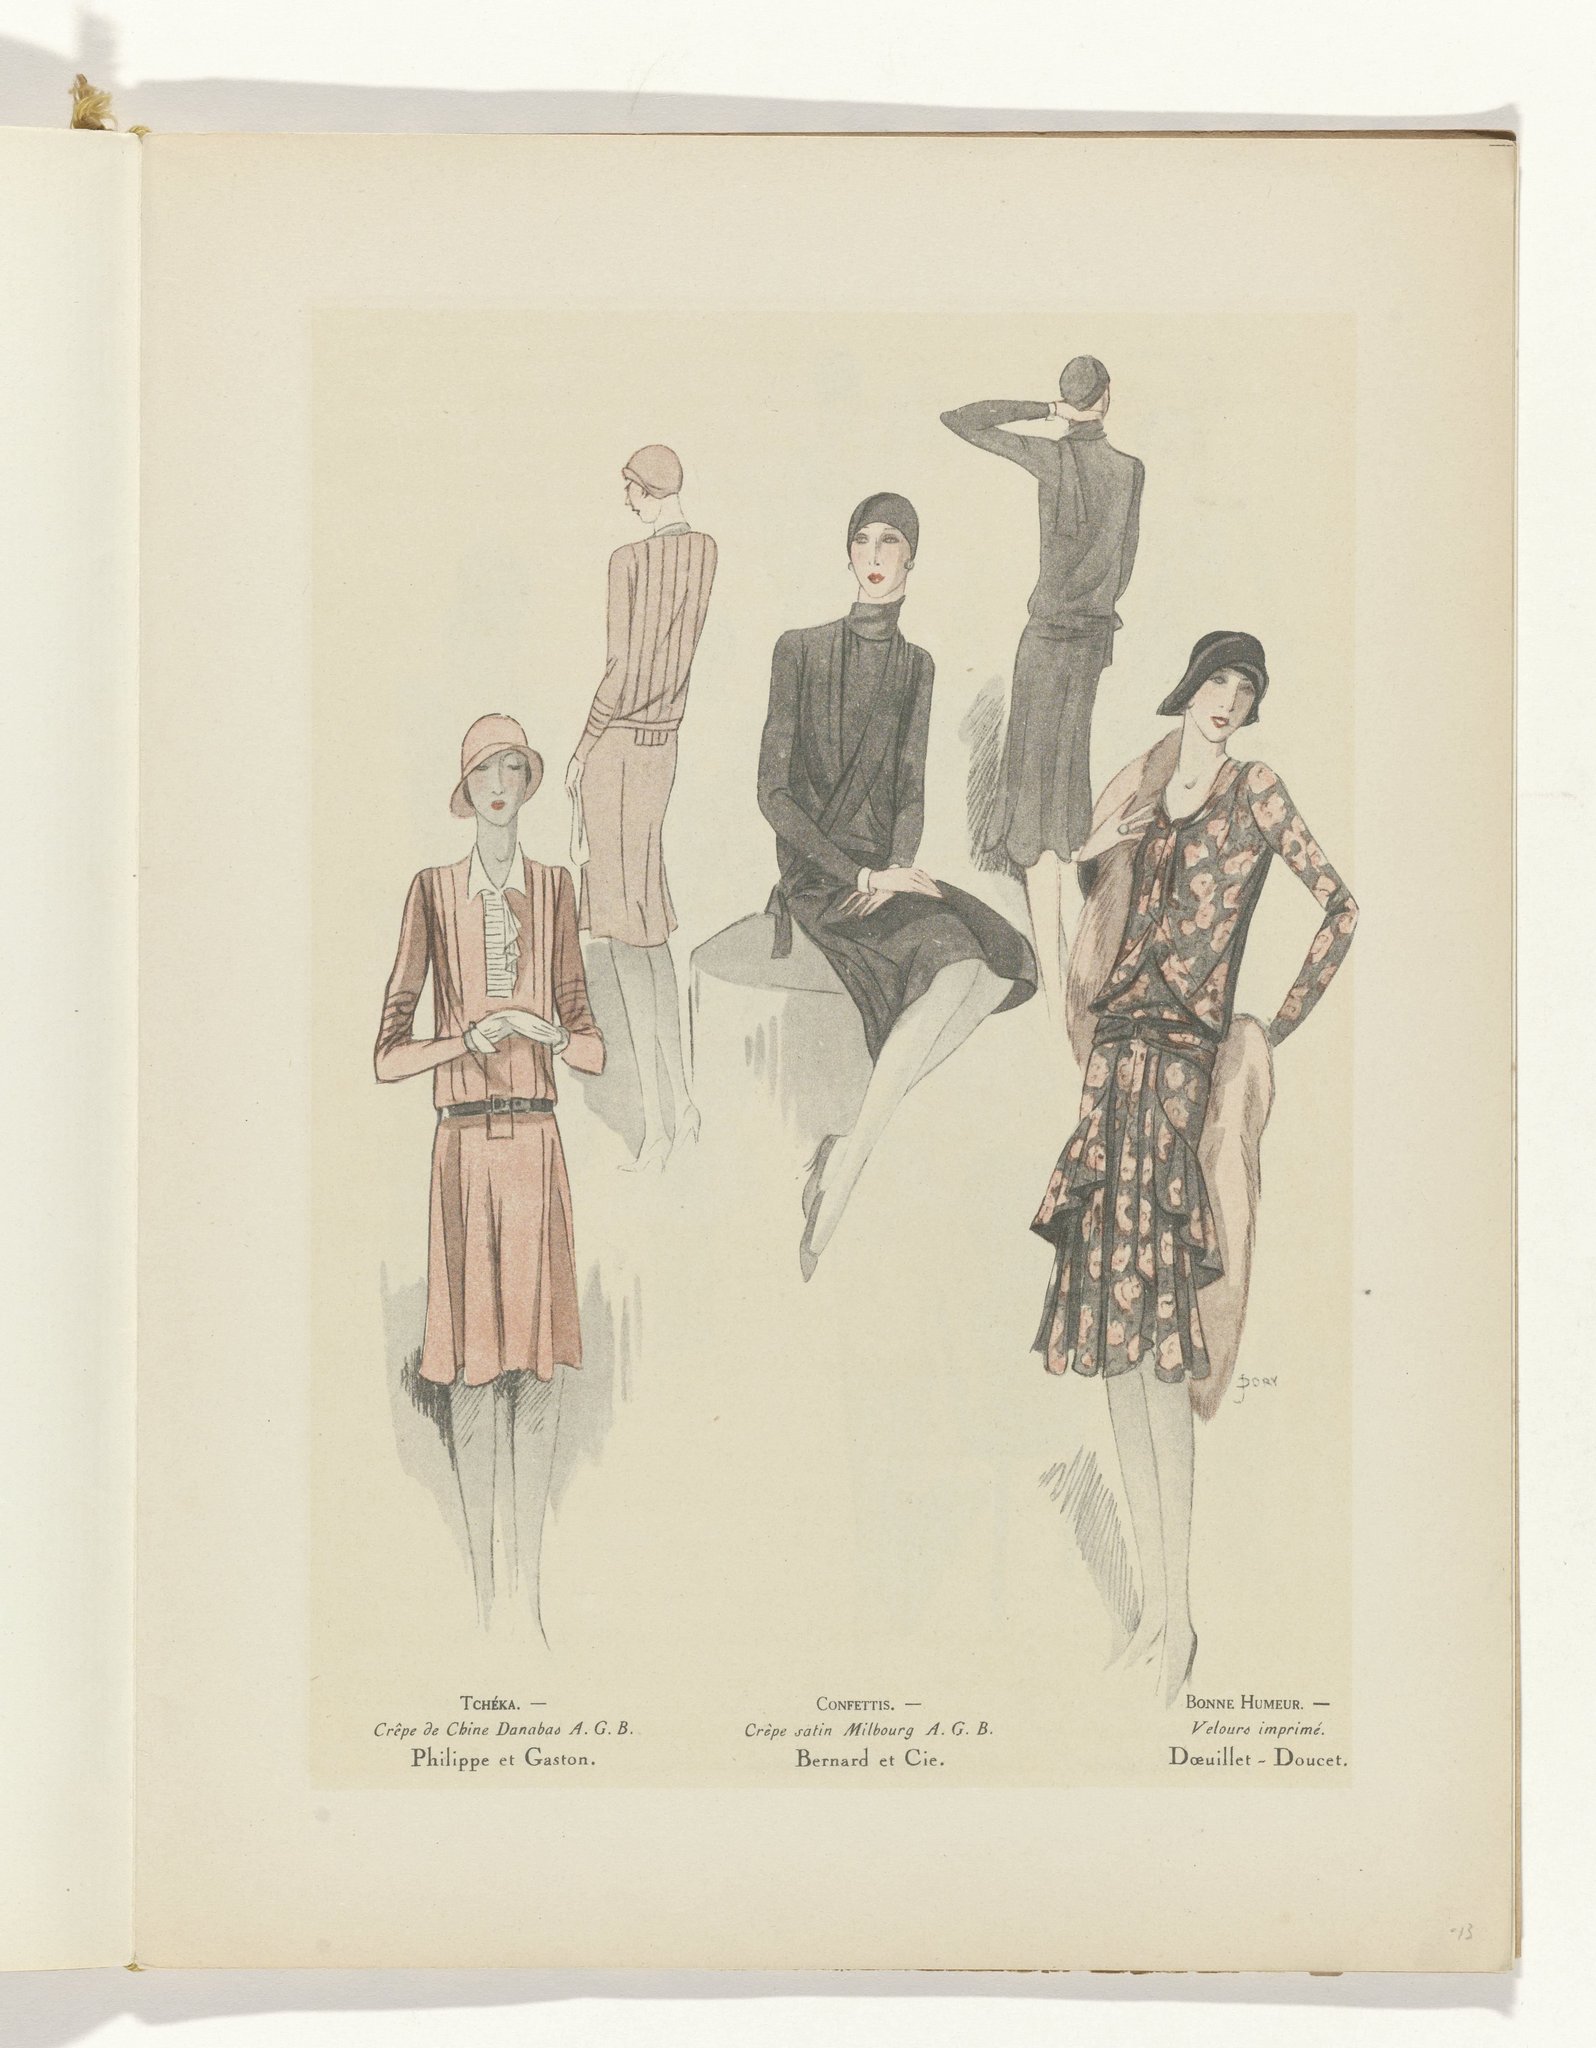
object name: fashion print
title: Art - Goût - Beauté, Feuillets de l' élégance féminine, Novembre 1928, No. 99, 9e Année, p. 13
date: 1928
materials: paper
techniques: printing, photography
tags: dress, gown: day dress (+ women's clothes), fashion plates, dress, gown (+ women's clothes), clothing for the upper part of the body (+ fur used for clothes), belt, girdle, waistband (+ women's clothes)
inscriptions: caption: ‘TCHÉKA. - Crêpe de Chine Danabas A.G.B. Philippe et Gaston. / CONFETTIS. - Crêpe satin Milbourg A.G.B. Bernard et Cie. / BONNE HUMEUR. - Velours imprimé. Doeuillet-Doucet.’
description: Links: jurk van 'crêpe de Chine Danabas A.G.B.', van Philippe et Gaston, Midden: jurk van 'crêpe satin' Milbourg A.G.B., van Bernard et Cie. Rechts: jurk van bedrukt fluweel, van Doeuillet - Doucet. Pagina uit het modetijdschrift Art-Goût-Beauté (1920-1933).